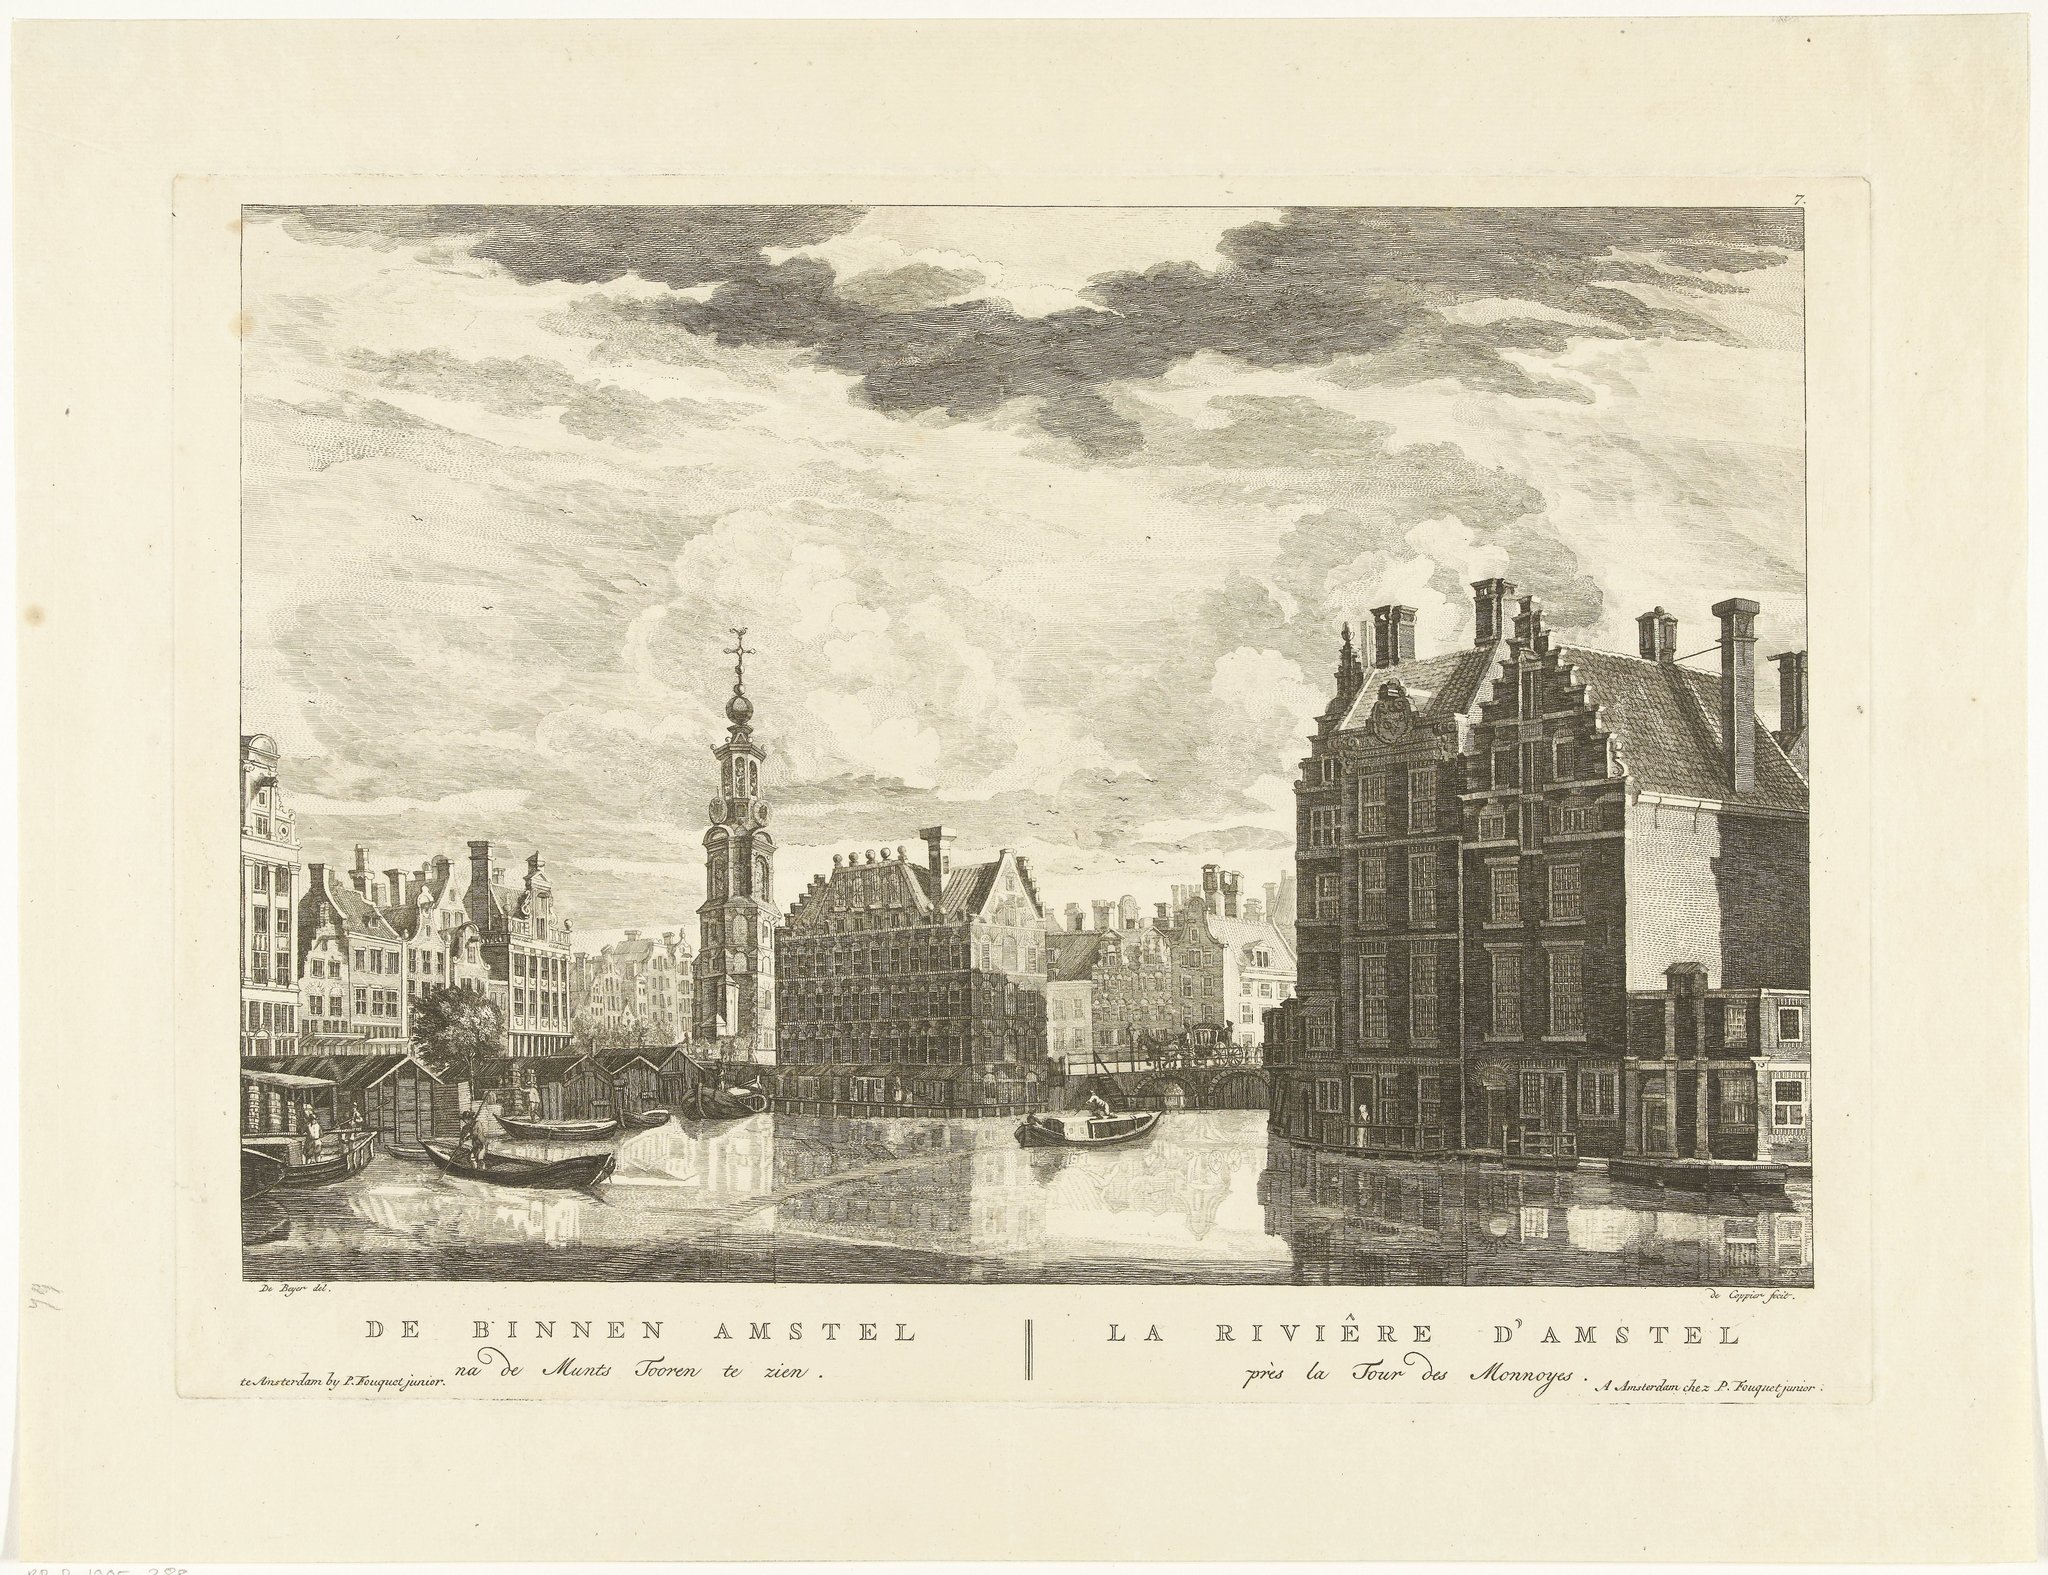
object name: print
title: Gezicht op de Binnen-Amstel en de Munttoren te Amsterdam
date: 1774-1783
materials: paper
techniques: engraving, etching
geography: amsterdam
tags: bridge in city across river, canal, etc. (+ city(-scape) with figures, staffage), tower, clock tower ~ monumental adornment, canals, waters (in city) (+ city(-scape) with figures, staffage)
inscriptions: collector's mark: Lugt 2228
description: Deze prent is ook gebruikt in de zogenaamde Atlas van Fouquet.* Pierre Fouquet gaf vanaf 1760 stadsgezichten van Amsterdam - naar tekeningen van verschillende kunstenaars, gemaakt door verschillende prentmakers - uit. Deze prenten werden aanvankelijk los of in series verkocht. Zoals toen gebruikelijk kon de koper de prenten zelf laten inbinden. Hiertoe gaf Fouquet tussen 1778 en 1783 een titelblad, plattegrond en inhoudsopgave van de tot dusver 100 uitgegeven prenten uit (1). Gezien de inhoud afhankelijk was van wat de koper had verzameld verschilt de inhoud van de verschillende bewaarde Fouquetatlassen onder deze titel sterk. Ook zijn er exemplaren bekend waar tevens andere prenten aan zijn toegevoegd. Omdat er behoefte bleek aan uitleg bij de platen werd in 1783 een nieuwe versie van de atlas uitgegeven, aangevuld met tekst en twee prenten. De aangegeven volgorde veranderde maar de platen van de al eerder uitgegeven prenten bleven ongewijzigd. Deze uitgave werd in opdracht van Fouquet gedrukt bij Daniël Jean Changuion en Petrus den Hengst (2). Een tiental platen werd bijgewerkt en verscheen, met nieuw impressum, in het vervolg van Wagenaars geschiedenis van Amsterdam, uitgeven door Petrus Conradi en Folkert van der Plaats (3). Een aantal jaar na het overlijden van Fouquet kwam Evert Maaskamp met een nieuwe uitgave van de atlas, met verbeterde tekst en toevoeging van twee prenten. Op alle platen verwijderde hij het oude en liet hij zijn eigen impressum zetten (4). De huidige staat van de prent komt voor in exemplaren van de onder (1) en (2) genoemde werken. * Onder de Atlas van Fouquet of Fouquetatlas verstaan we de hieronder vermelde publicaties (1), (2) en (4). (1). Afbeeldingen van de wyd-vermaarde koopstad Amsterdam benevens des zelvs voornaamste gebouwen en gezigten alle naar het leeven getekend / Receuil des edifices les plus considerables et des plus belles vues, de la fameuse ville d'Amsterdam, dessinées d'après nature. Amsterdam: Pierre Fouquet, 1778-1783. (2). Nieuwe atlas, van de voornaamste gebouwen en gezigten der stad Amsterdam, met derzelver beknopte beschryvingen. 2 delen. Amsterdam: Daniël Jean Changuion en Petrus den Hengst [in opdracht van Pierre Fouquet], 1783. (3). Stijl, Simon. Amsterdam, in zyne geschiedenissen, voorregten, koophandel, gebouwen, kerkenstaat, schoolen, schutterye, gilden en regeeringe, beschreeven. Om te dienen ten vervolge op het werk van Jan Wagenaar (…). 10 delen. Amsterdam en Harlingen: Petrus Conradi en Folkert van der Plaats, 1788-1801. (4). Nieuwe atlas, van de voornaamste gebouwen en gezigten der stad Amsterdam. Met derzelver beknopte beschryvingen. Amsterdam: Evert Maaskamp, 1805. * Het aantal vermelde staten is gebaseerd op het aantal gevonden staten. Mogelijk zijn er meer staten van deze prent. Voor eerste bekende staat RP-P-1921-303. Voor vierde bekende staat zie RP-P-AO-27-52A.